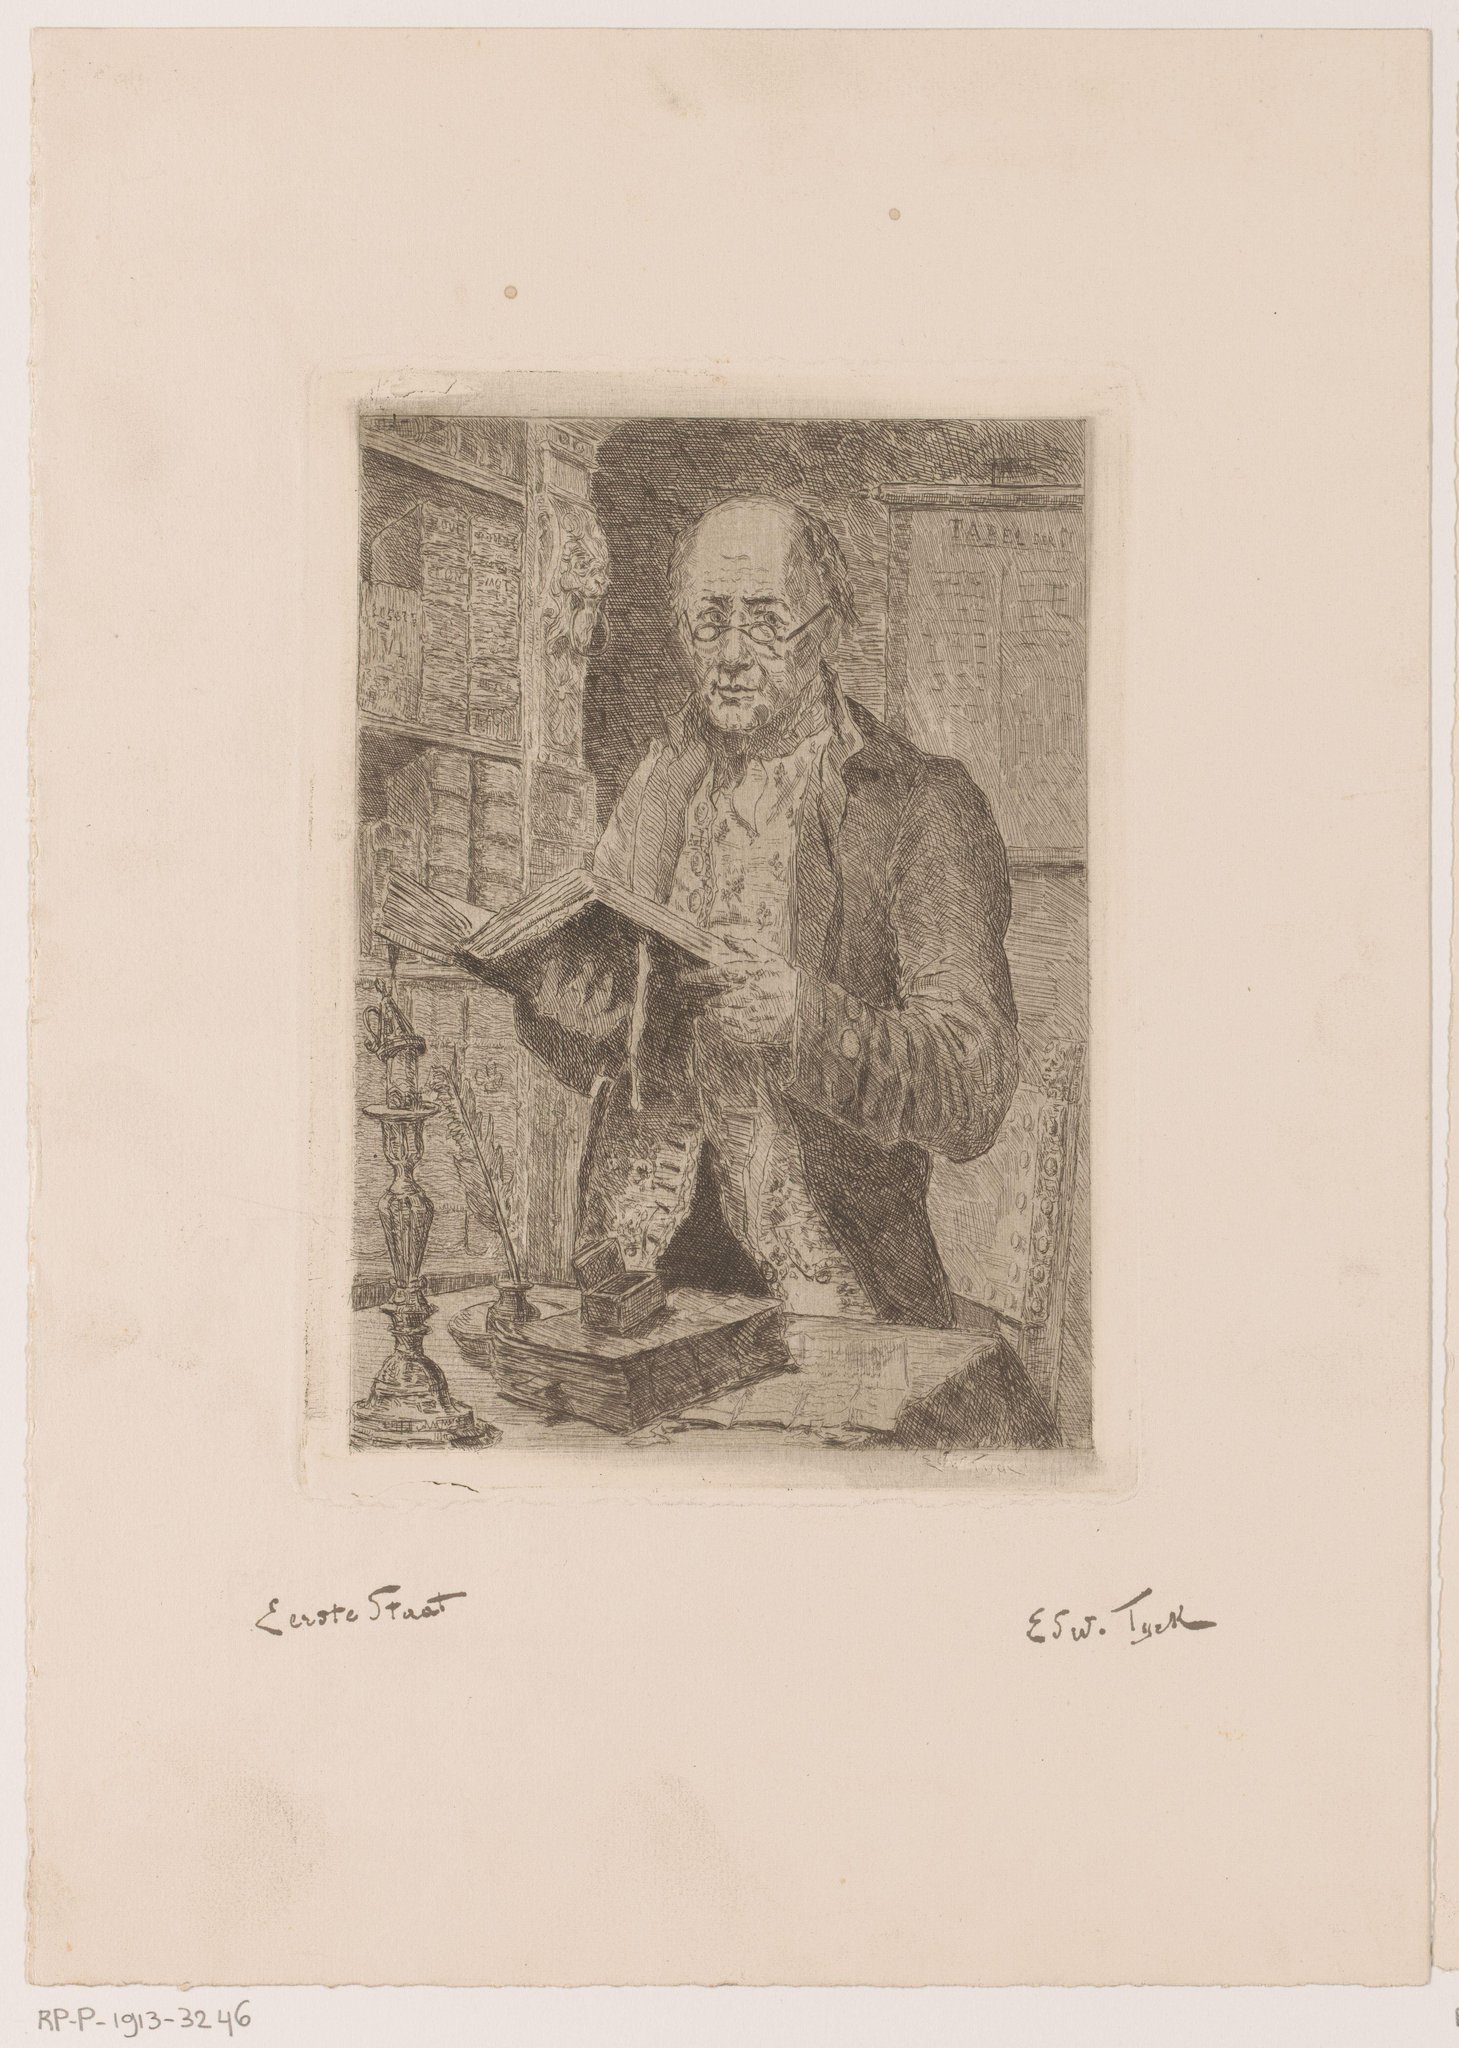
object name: print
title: Man met opengeslagen boek en leesbril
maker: edouard tyck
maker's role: print maker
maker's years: 1847-1922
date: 1857-1913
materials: paper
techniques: drypoint, etching, intaglio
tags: eyeglasses, spectacles, reading, old man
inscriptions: collector's mark: Lugt 2228